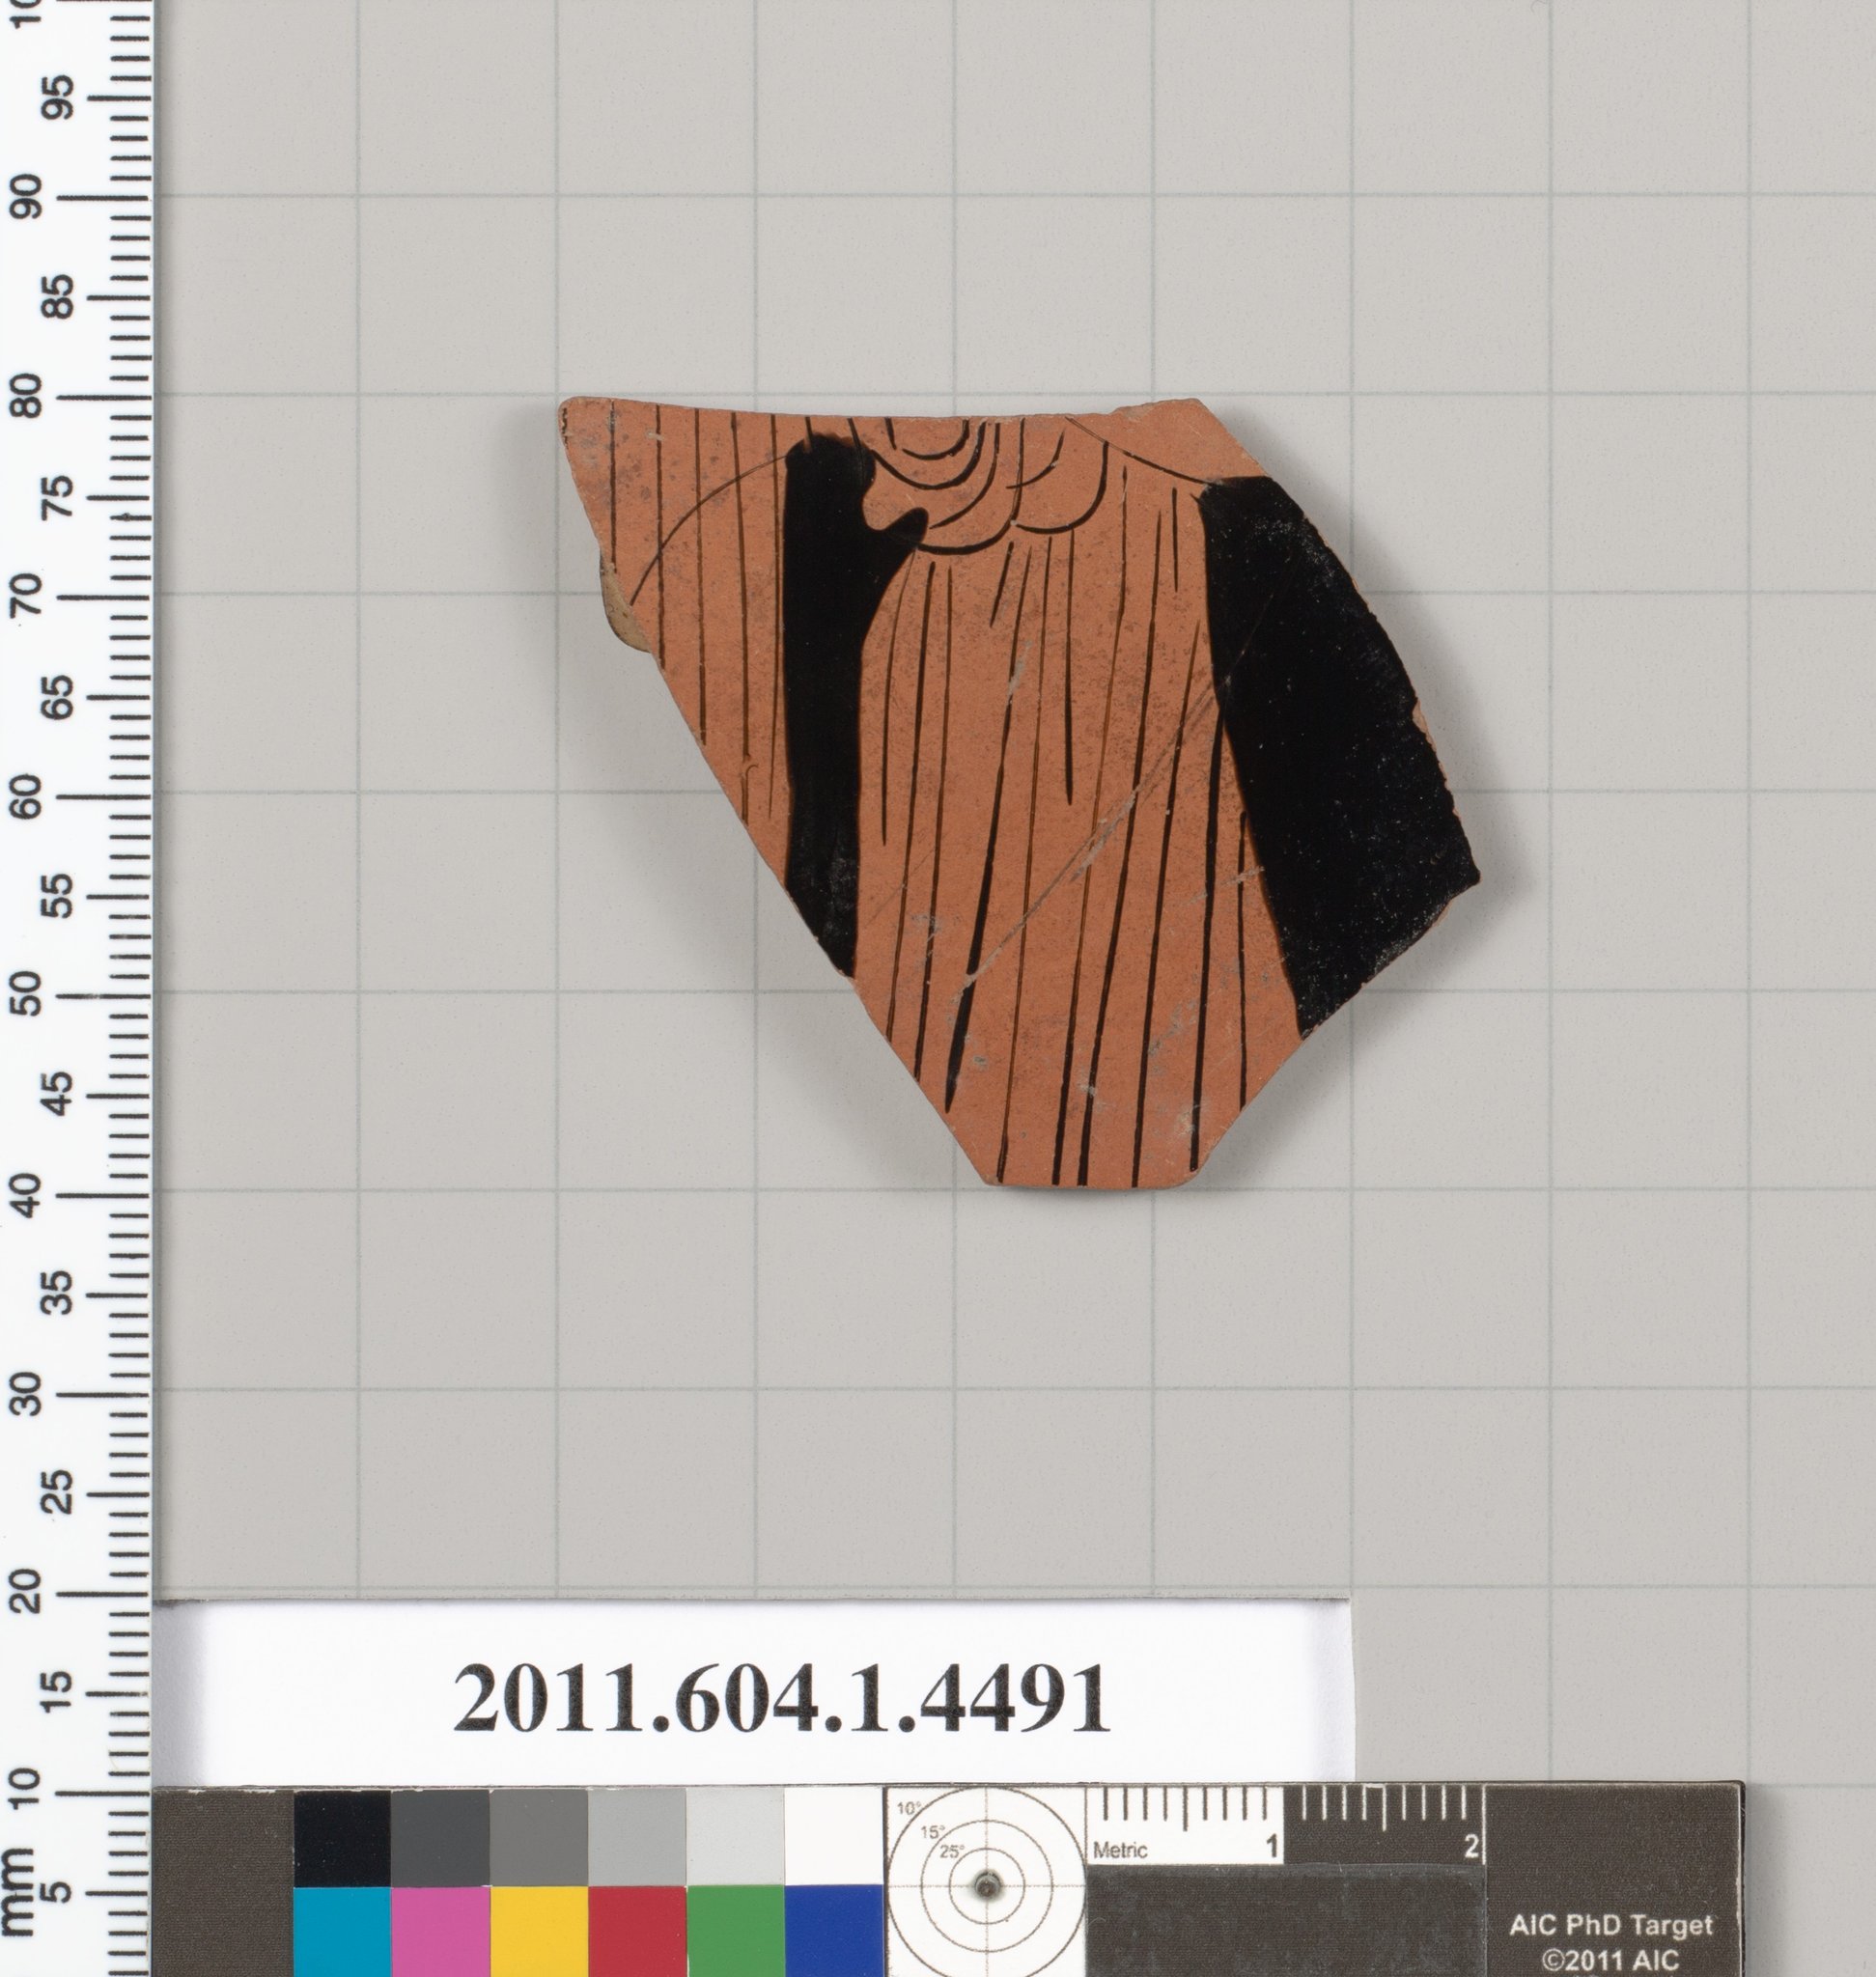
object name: kylix fragment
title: Terracotta fragment of a kylix (drinking cup)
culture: greek, attic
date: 475-451 BCE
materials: terracotta